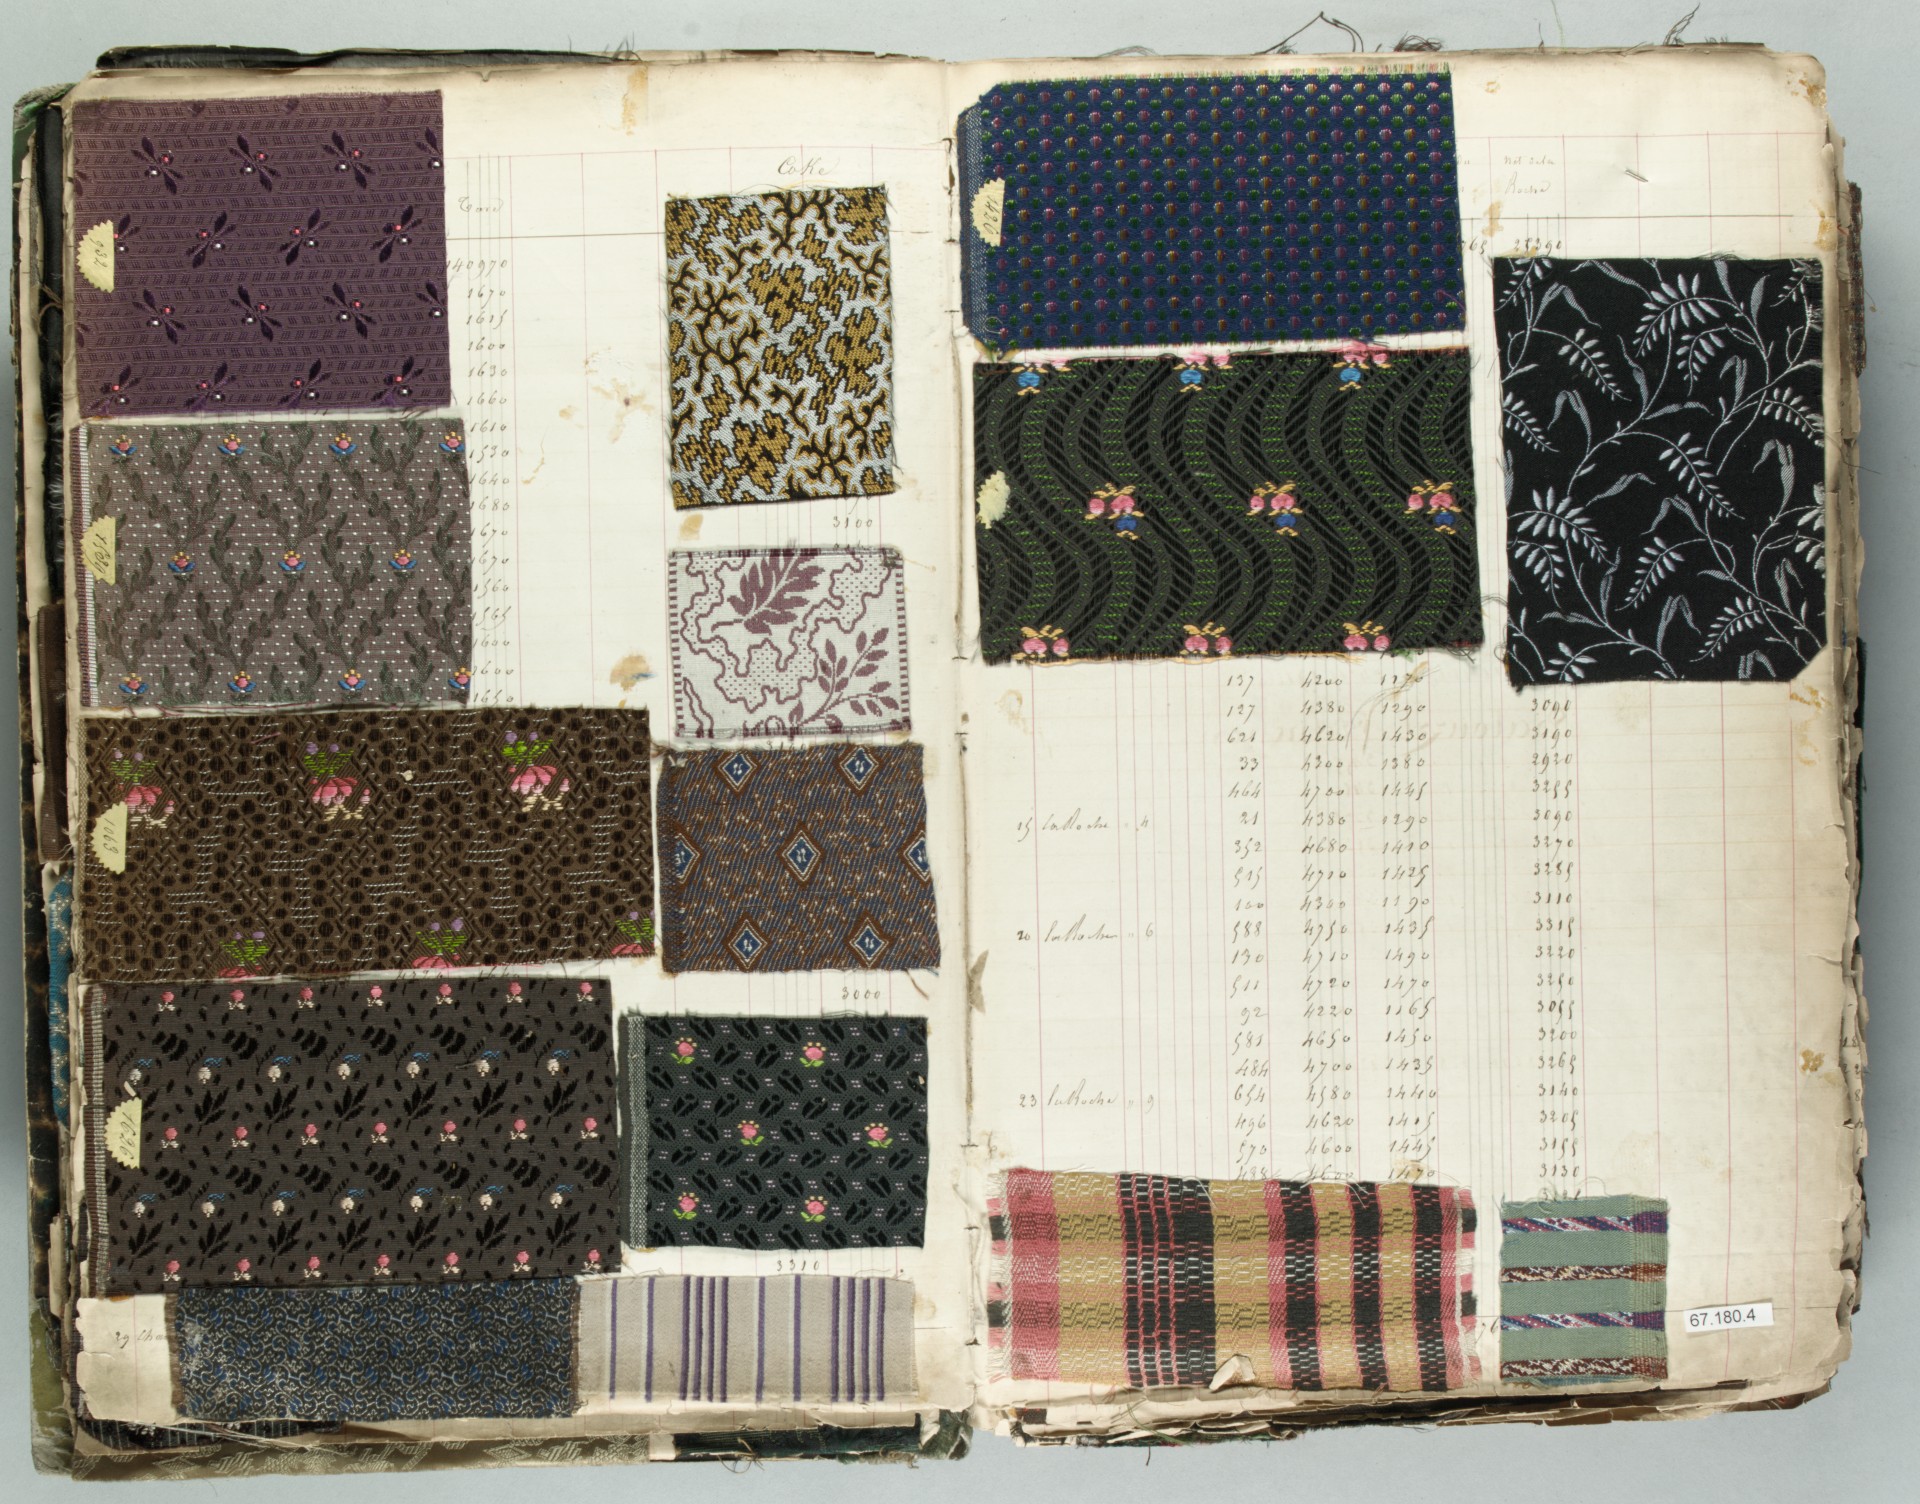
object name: sample book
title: Textile Sample Book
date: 1843